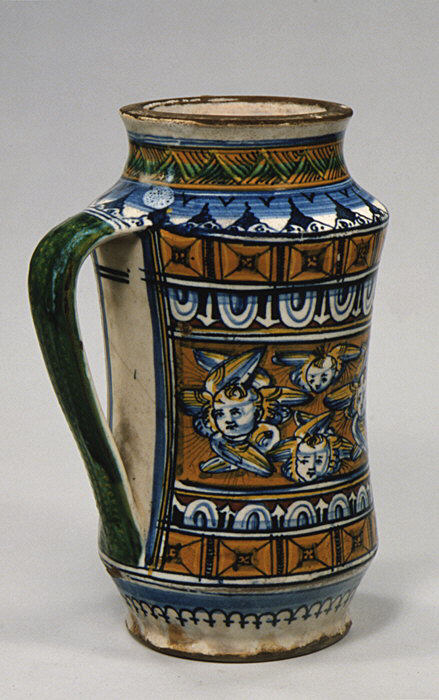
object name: storage jar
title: One-handled storage jar (albarello)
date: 1510-1530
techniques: maiolica, glazing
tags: heads